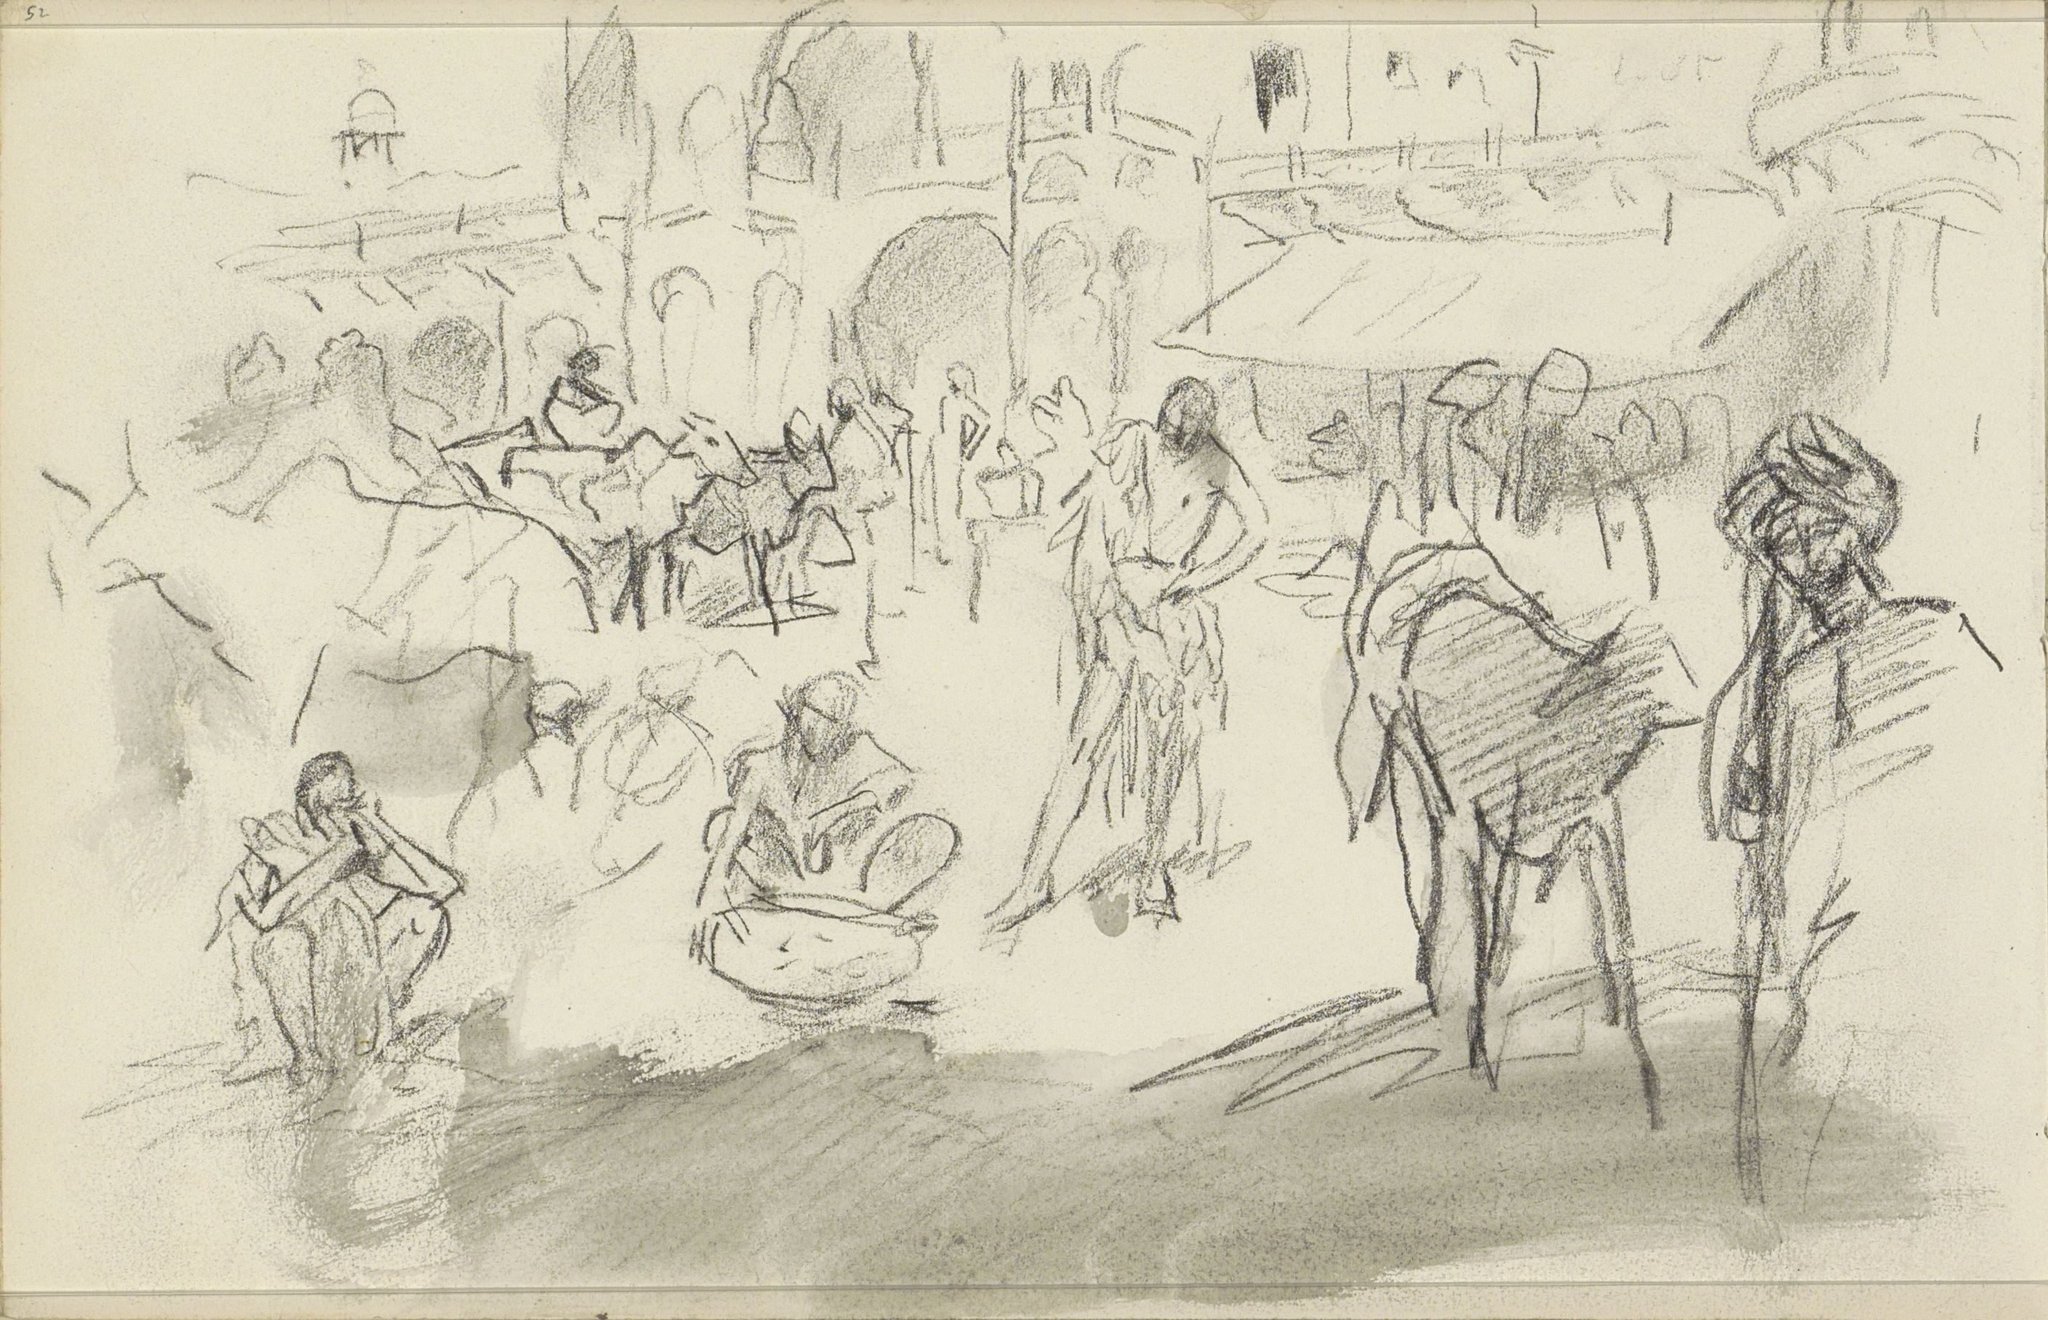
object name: sketchbook leaf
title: Indiase straatscène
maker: marius bauer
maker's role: draughtsman, print maker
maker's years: 1867-1932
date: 1924-1925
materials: chalk, paper, watercolor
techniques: brush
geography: india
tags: asiatic races and peoples: indians, street (+ city(-scape) with figures, staffage)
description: Pagina 52 uit een schetsboek met 48 bladen.